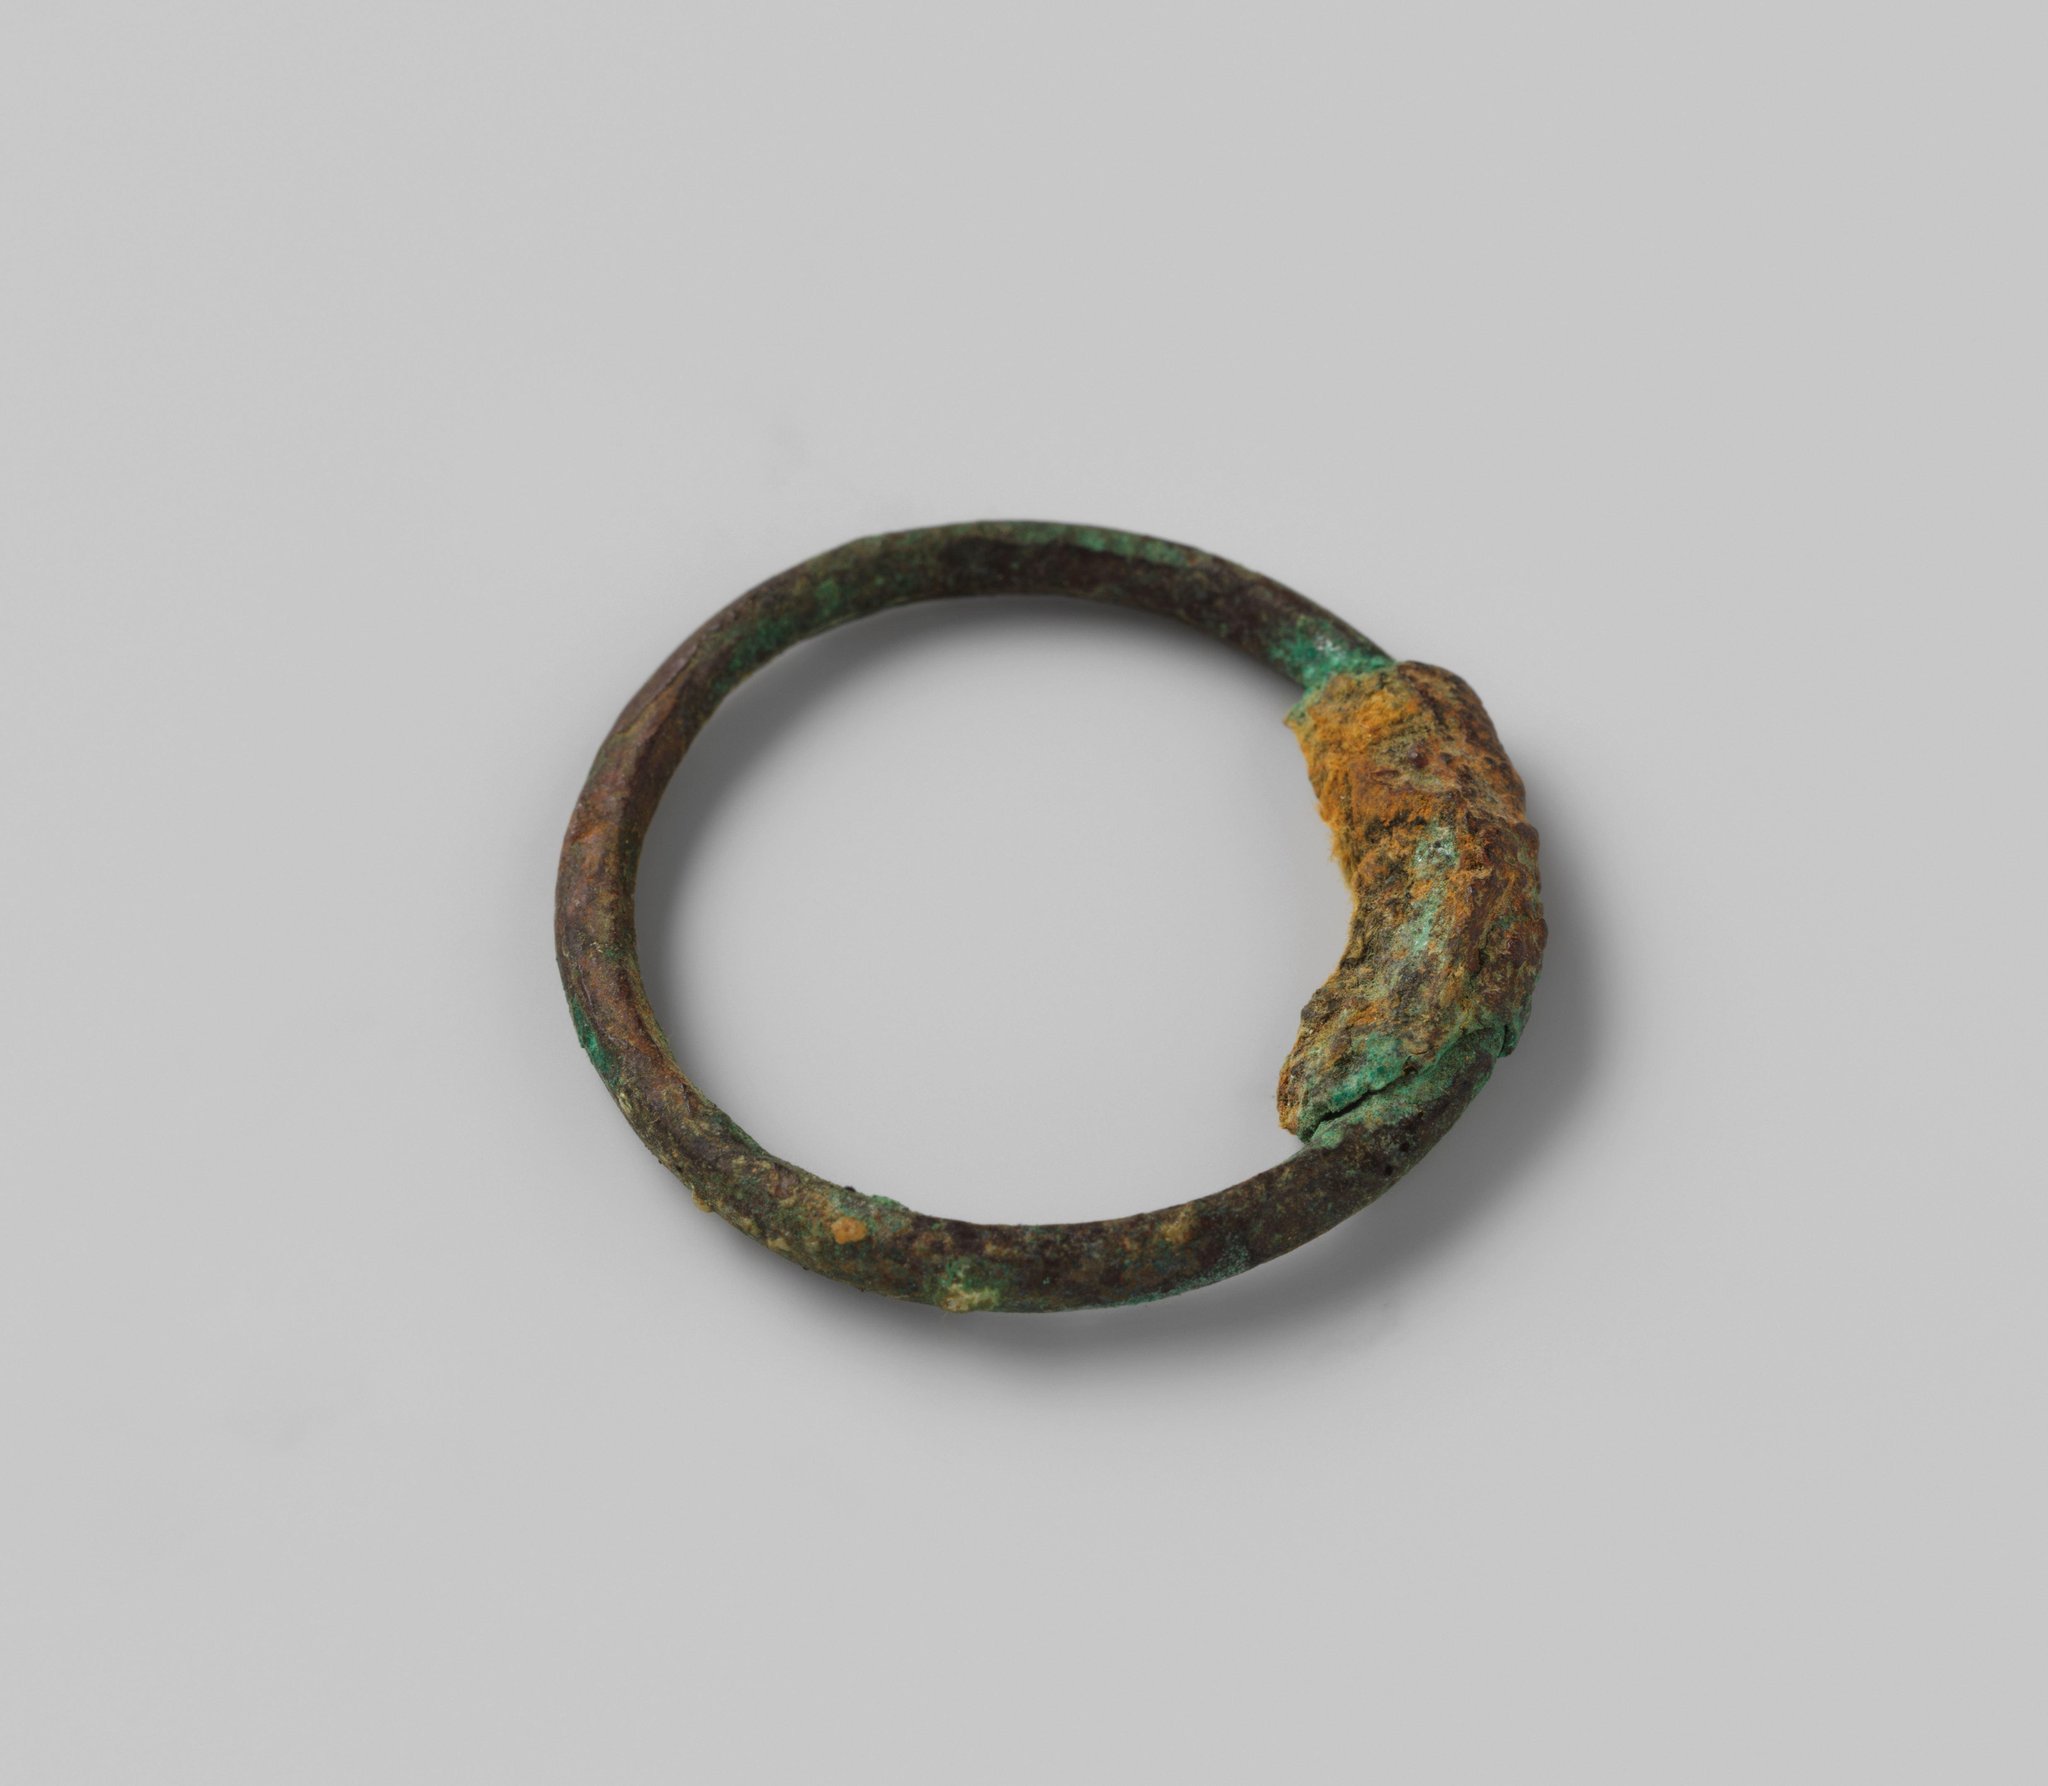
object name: ring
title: Ringvormig fragment uit het wrak van de Oost-Indiëvaarder Hollandia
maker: Anonymous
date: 1700-1743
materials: copper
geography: netherlands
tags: verenigde oostindische compagnie, hollandia (schip), annet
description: Varied parts or fragments, rings or ring-shaped fragments; id. 80H946.